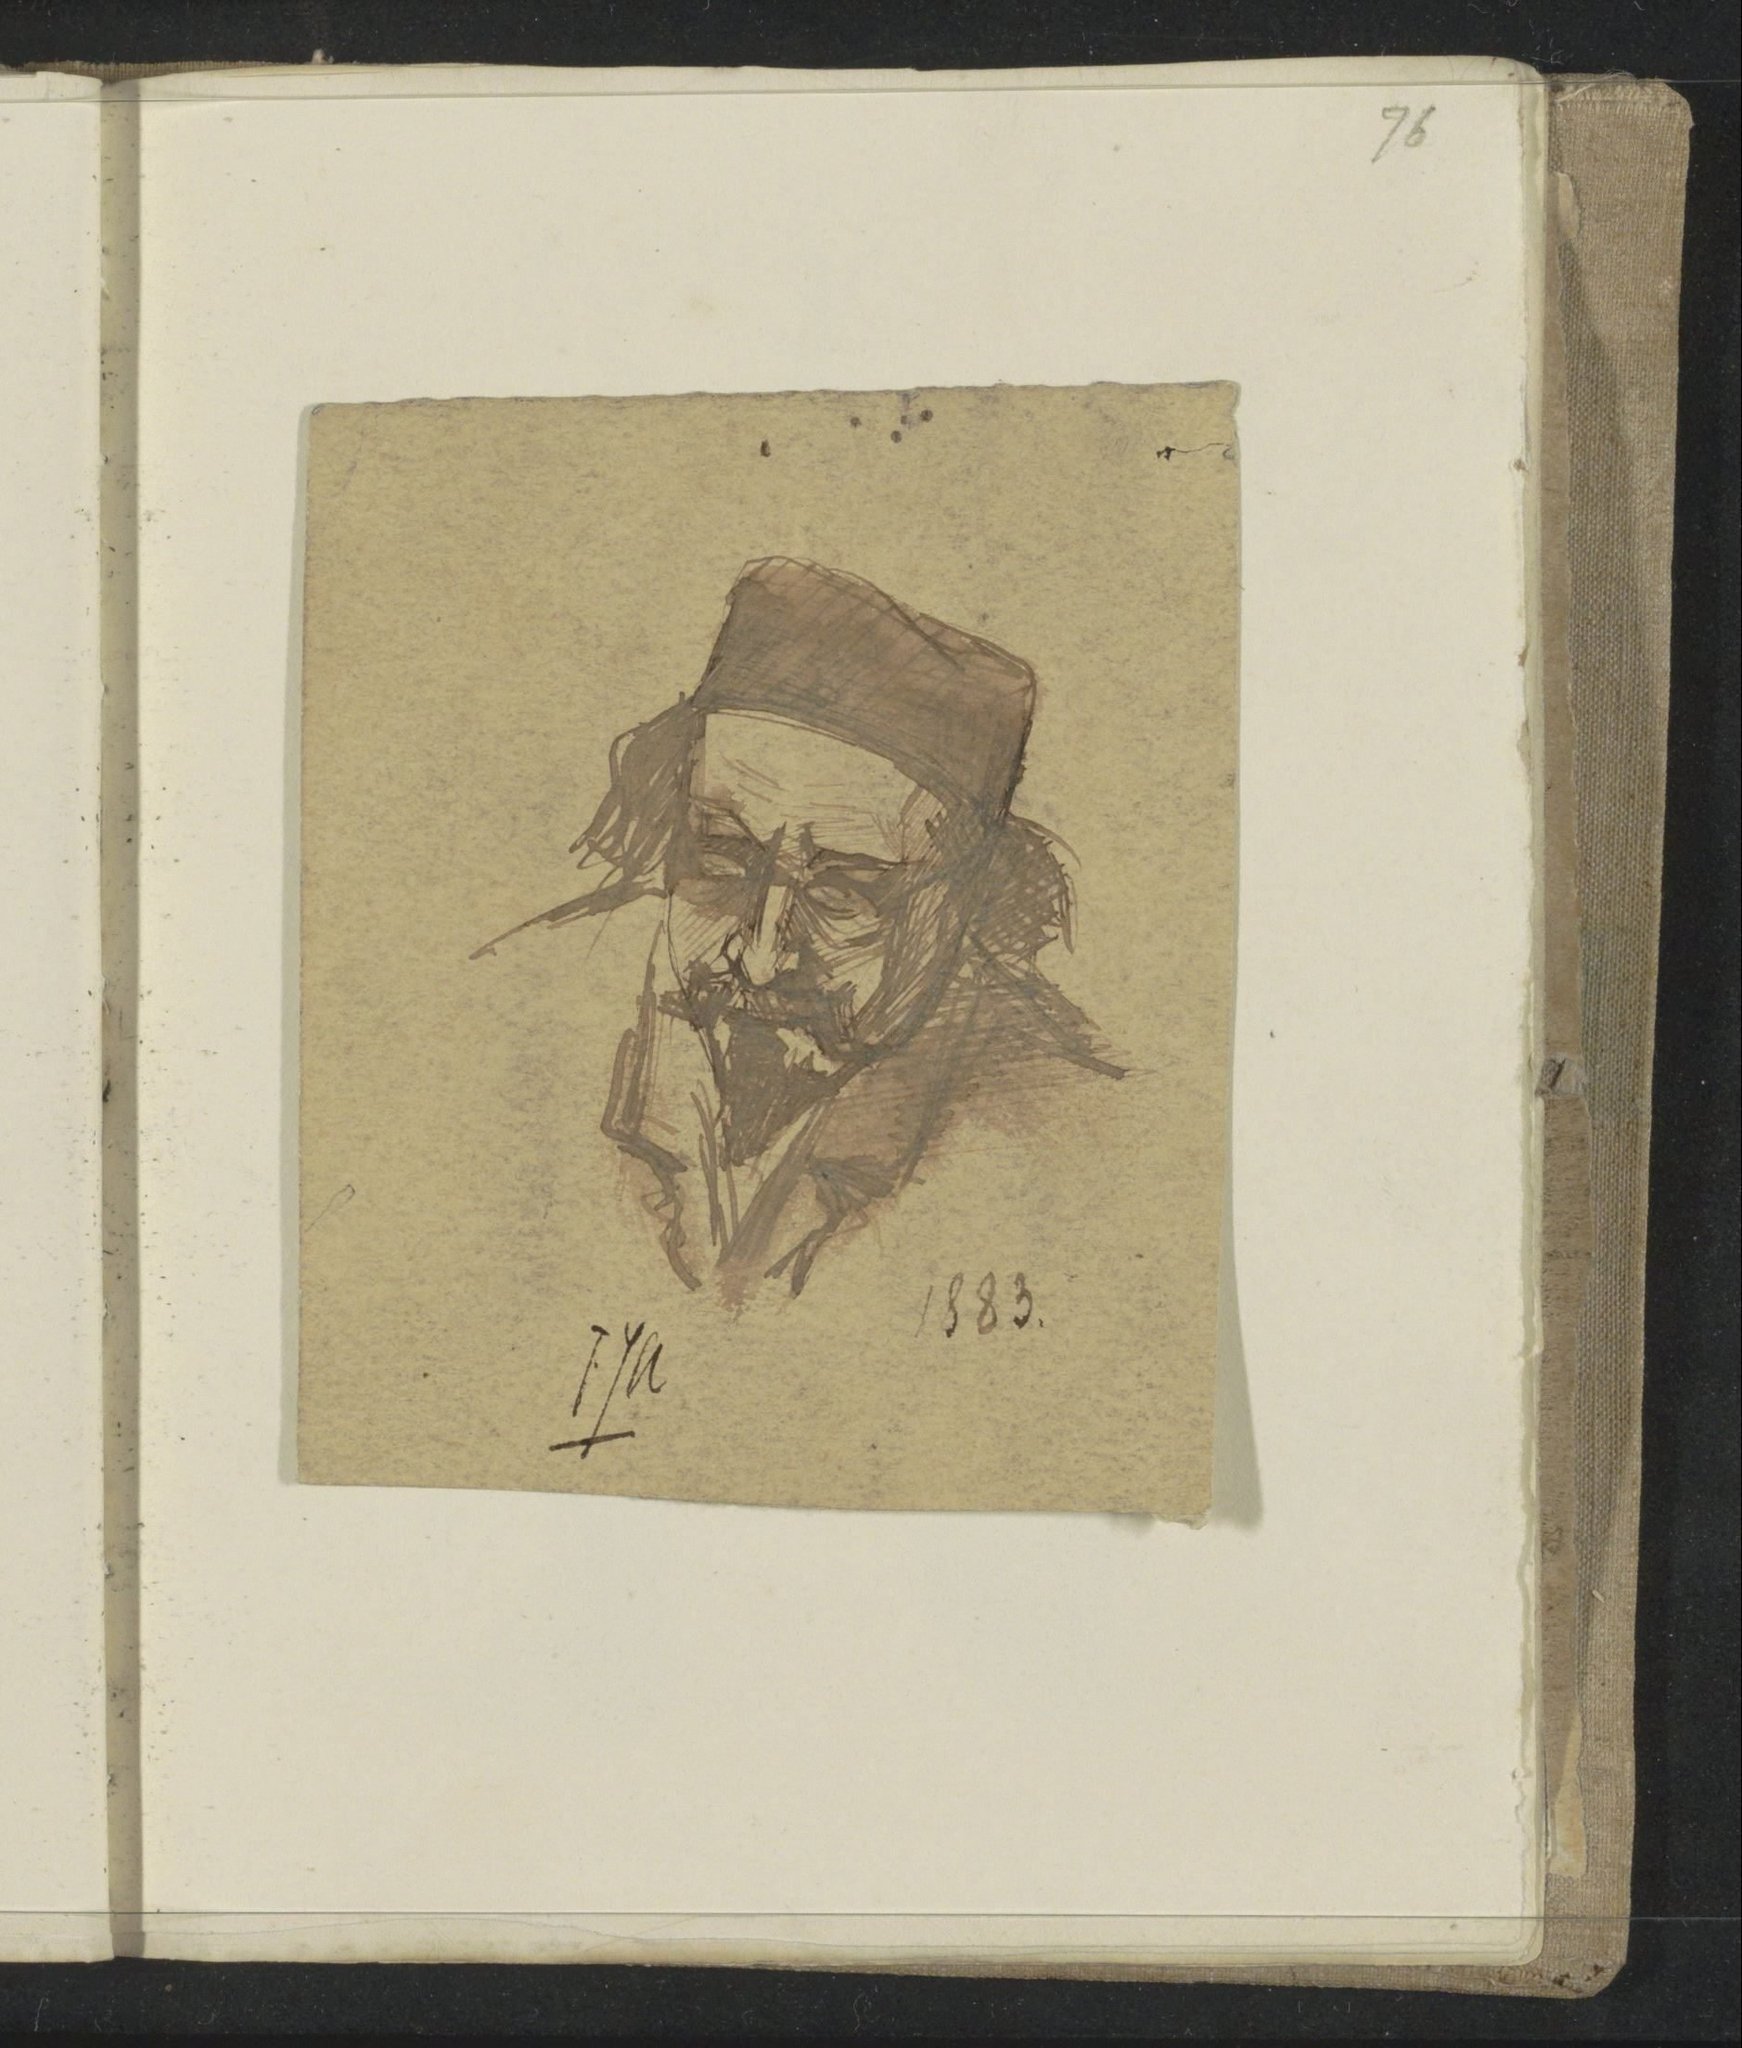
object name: sketchbook leaf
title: Portret van een onbekende man met bril en hoofddeksel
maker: floris arntzenius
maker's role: draughtsman, print maker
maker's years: 1864-1925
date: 1883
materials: cardboard, ink, paper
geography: the hague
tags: eyeglasses, spectacles, head-gear: hat (+ men's clothes), anonymous historical person portrayed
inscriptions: date: ‘1883.’, signature: ‘FJA’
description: Blad, geplakt op pagina 76 uit een schetsboek met 82 pagina's.